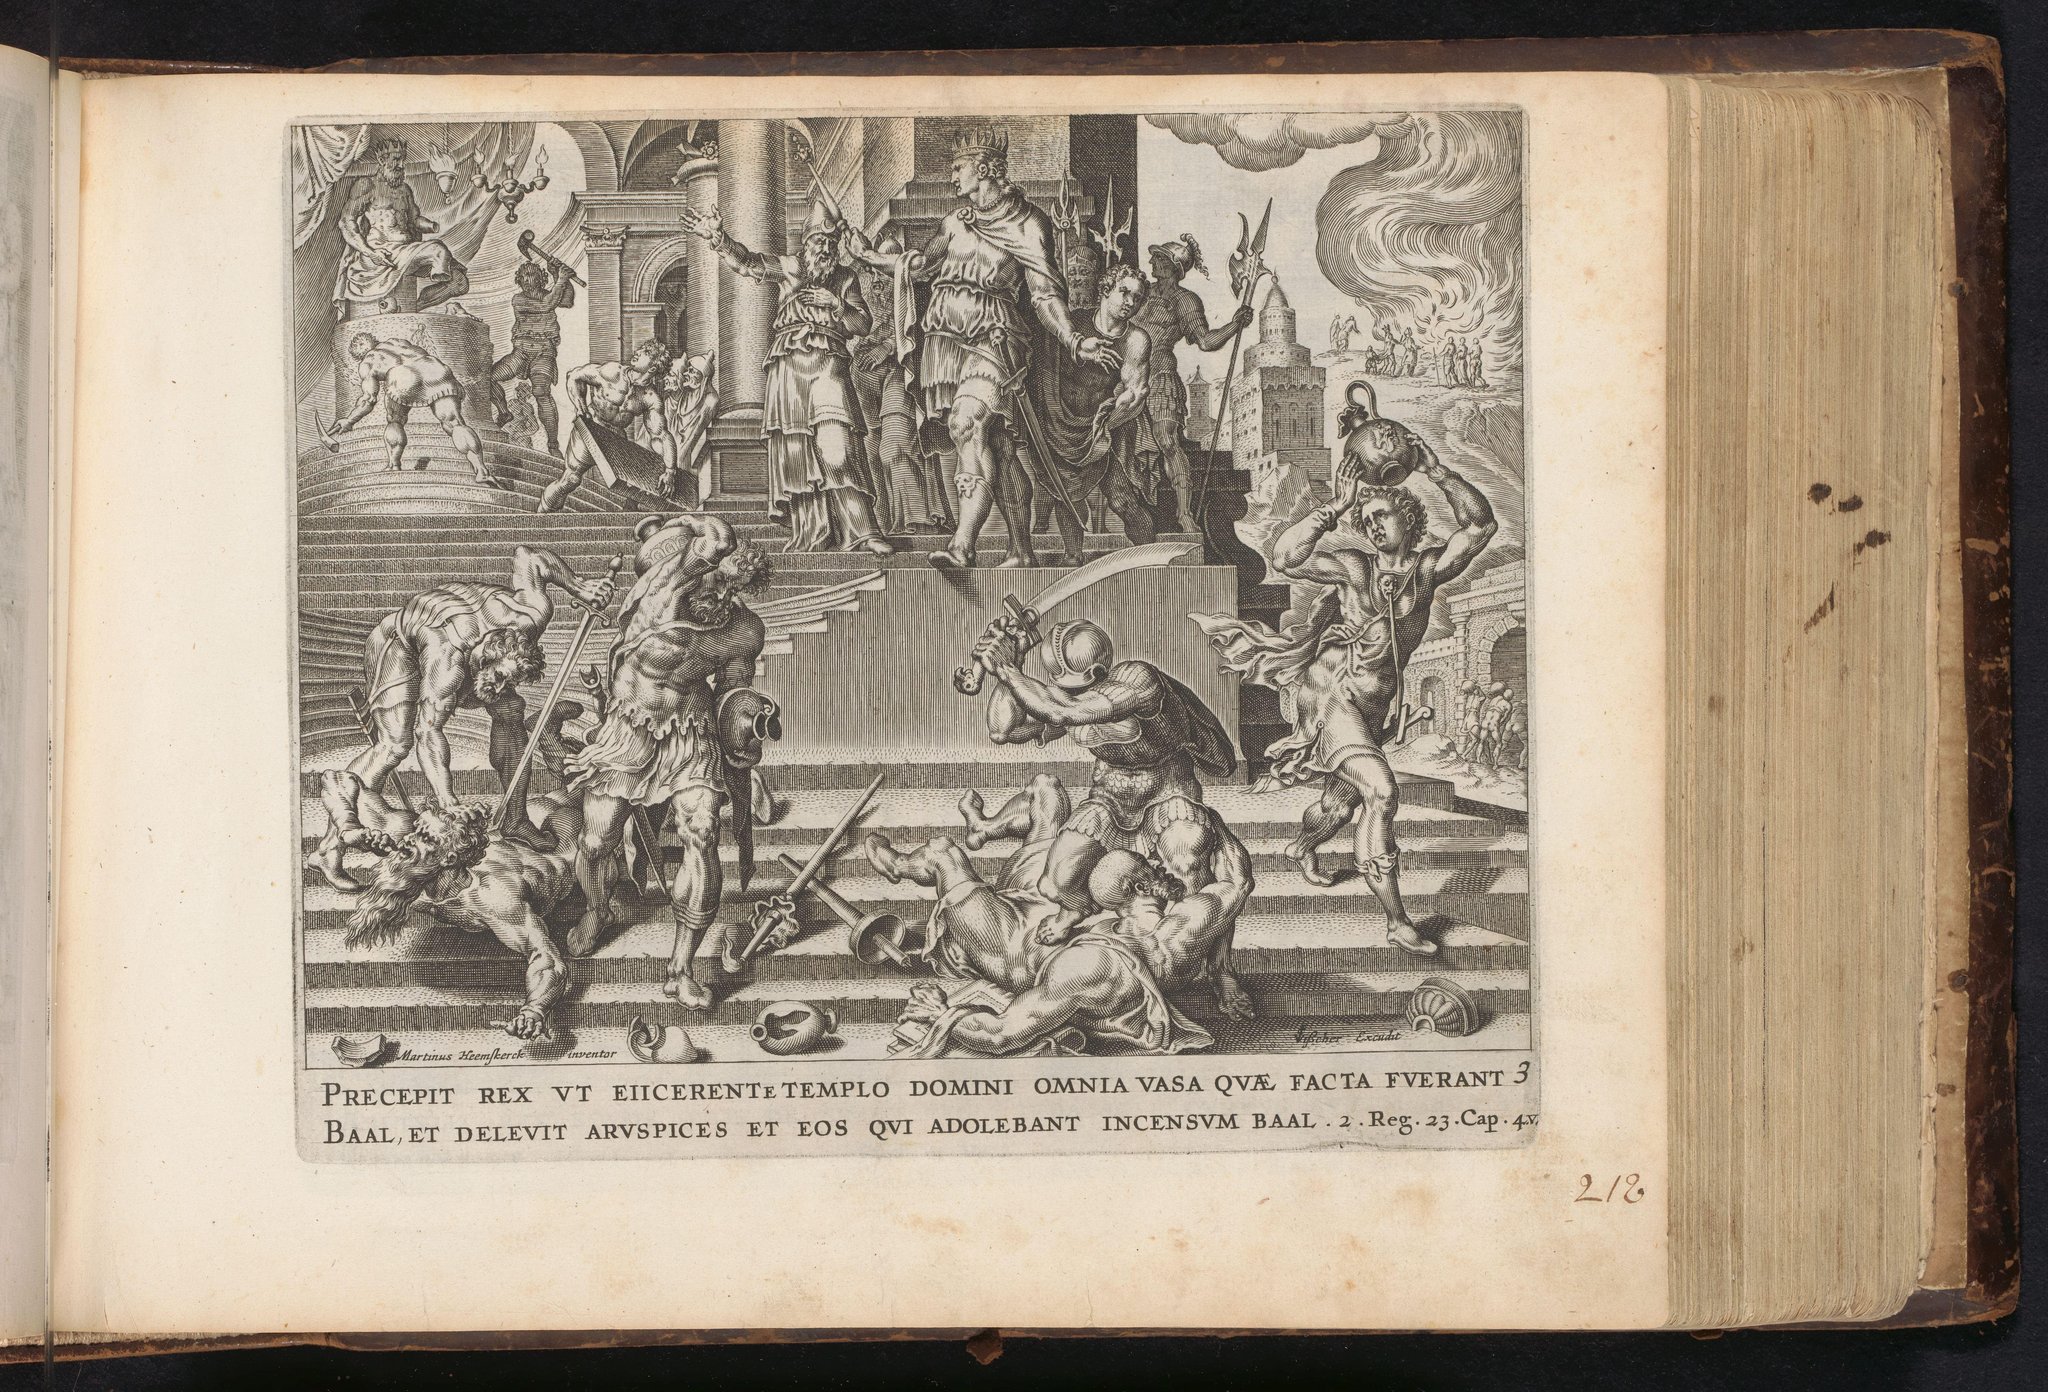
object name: print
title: Van den Coninck Josias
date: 1643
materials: paper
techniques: engraving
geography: alkmaar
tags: josiah does away with pagan worship, all the idols are brought out of the temple, burned, and their ashes pounded to dust ~ story of josiah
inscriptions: number: ‘218’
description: Koning Josia geeft opdracht om de tempel van Baäl te verwoesten en de Baälpriesters te vermoorden. Alle voorwerpen die ter ere van de afgod zijn gemaakt worden buiten de stad verbrand. Rechtsachter is het vuur te zien. Onder de voorstelling een verwijzing in het Latijn naar de Bijbeltekst in 2 Kon. 23:4. Deze prent maakt deel uit van een album.